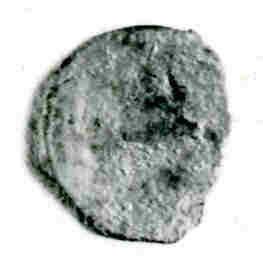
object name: coin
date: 701-900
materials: copper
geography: iran